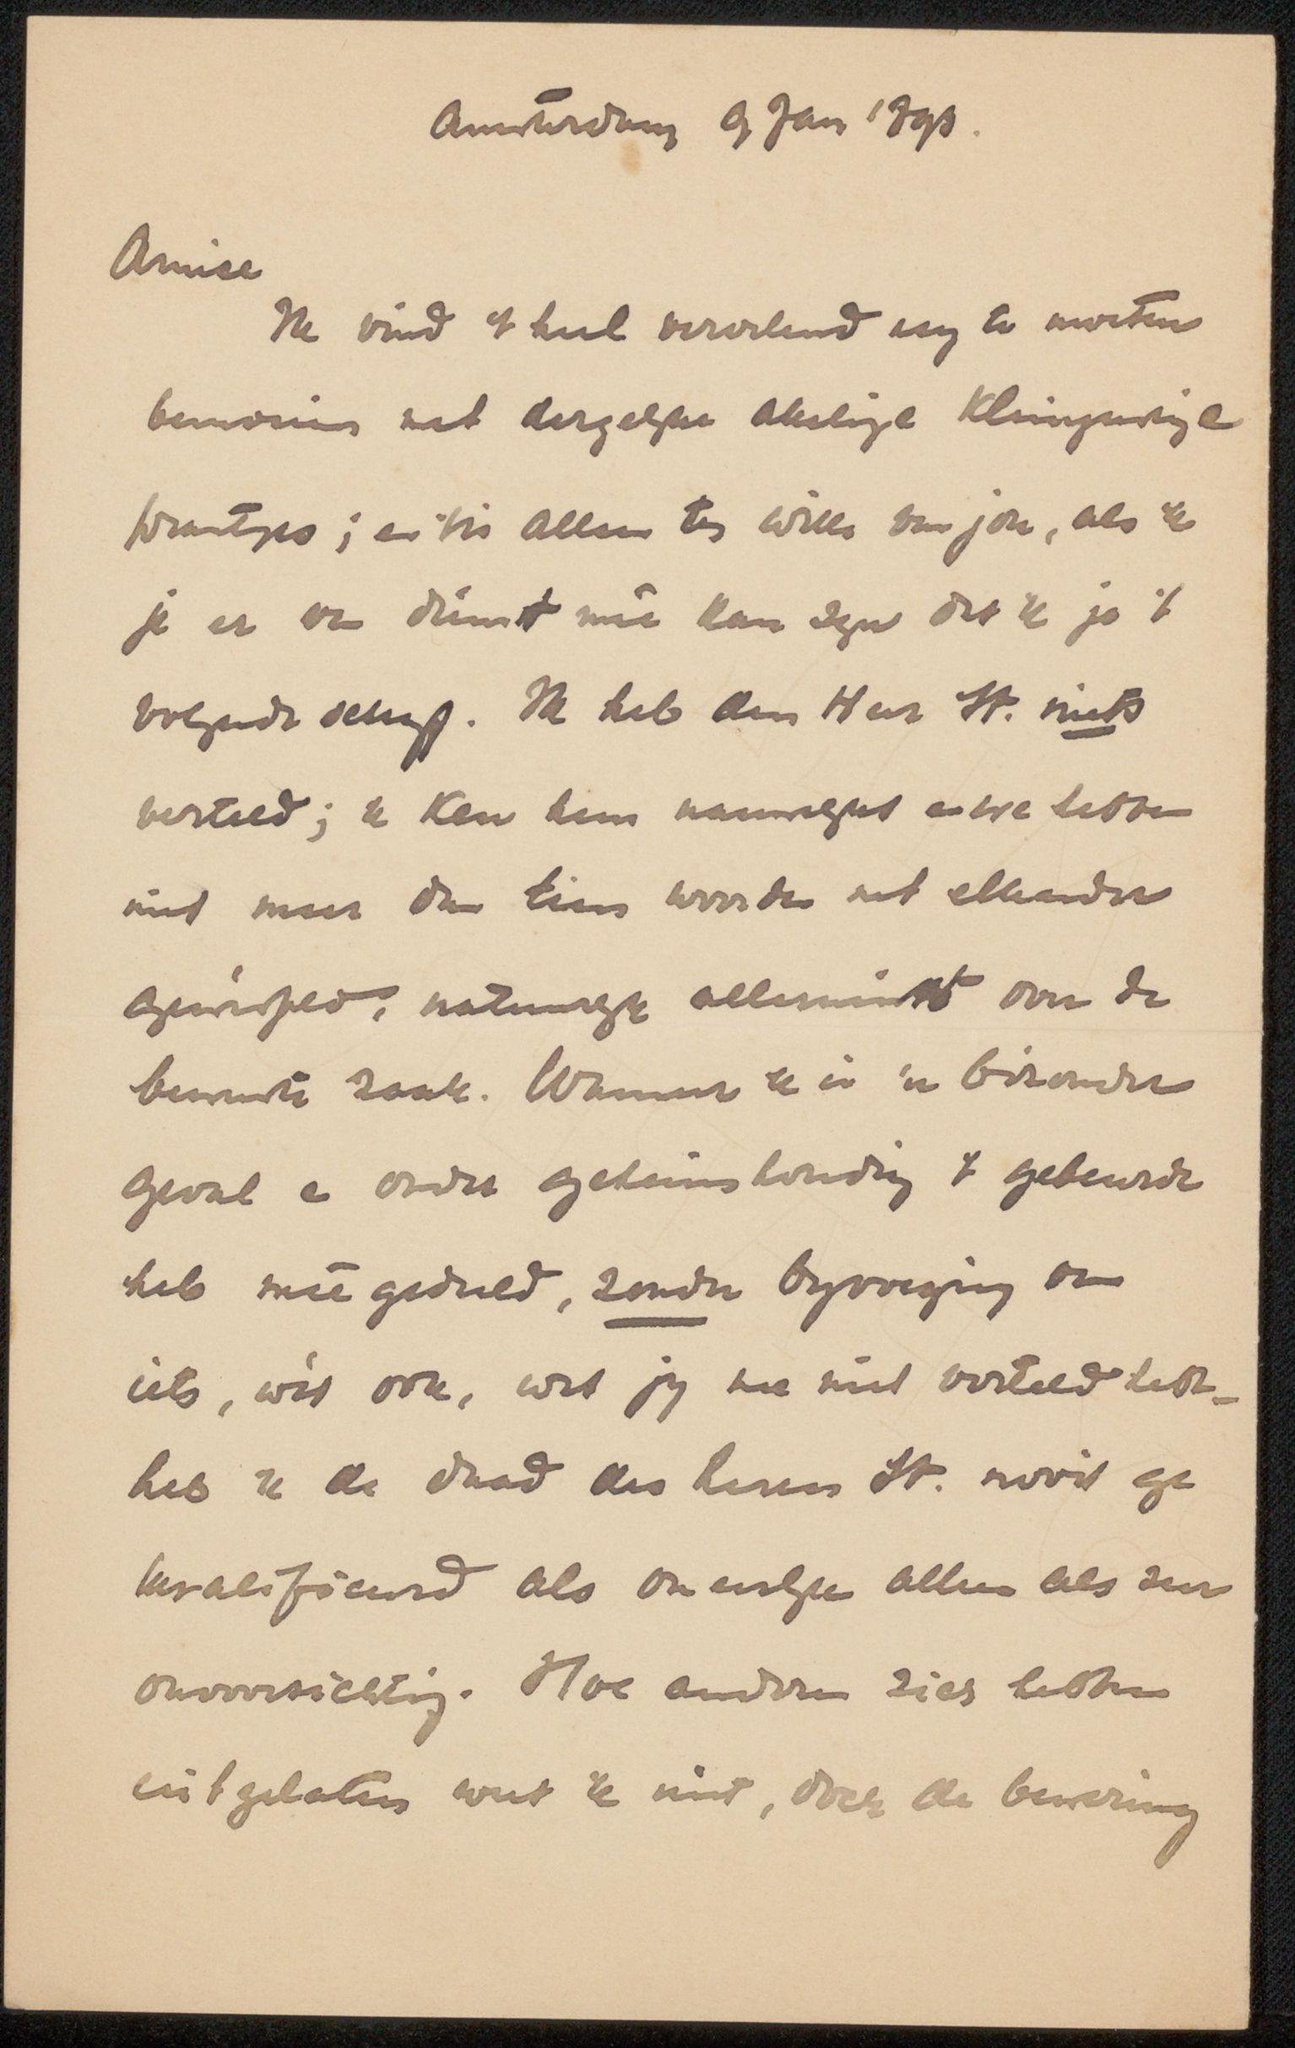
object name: letter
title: Brief aan Philip Zilcken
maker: willem witsen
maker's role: draughtsman, painter, print maker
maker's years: 1860-1923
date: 1893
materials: ink, paper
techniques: pen, writing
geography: amsterdam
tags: paris, paul verlaine, deventer, elisabeth van vloten, philip zilcken, money, leiden, amsterdam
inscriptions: watermark, collector's mark: ‘RPK’